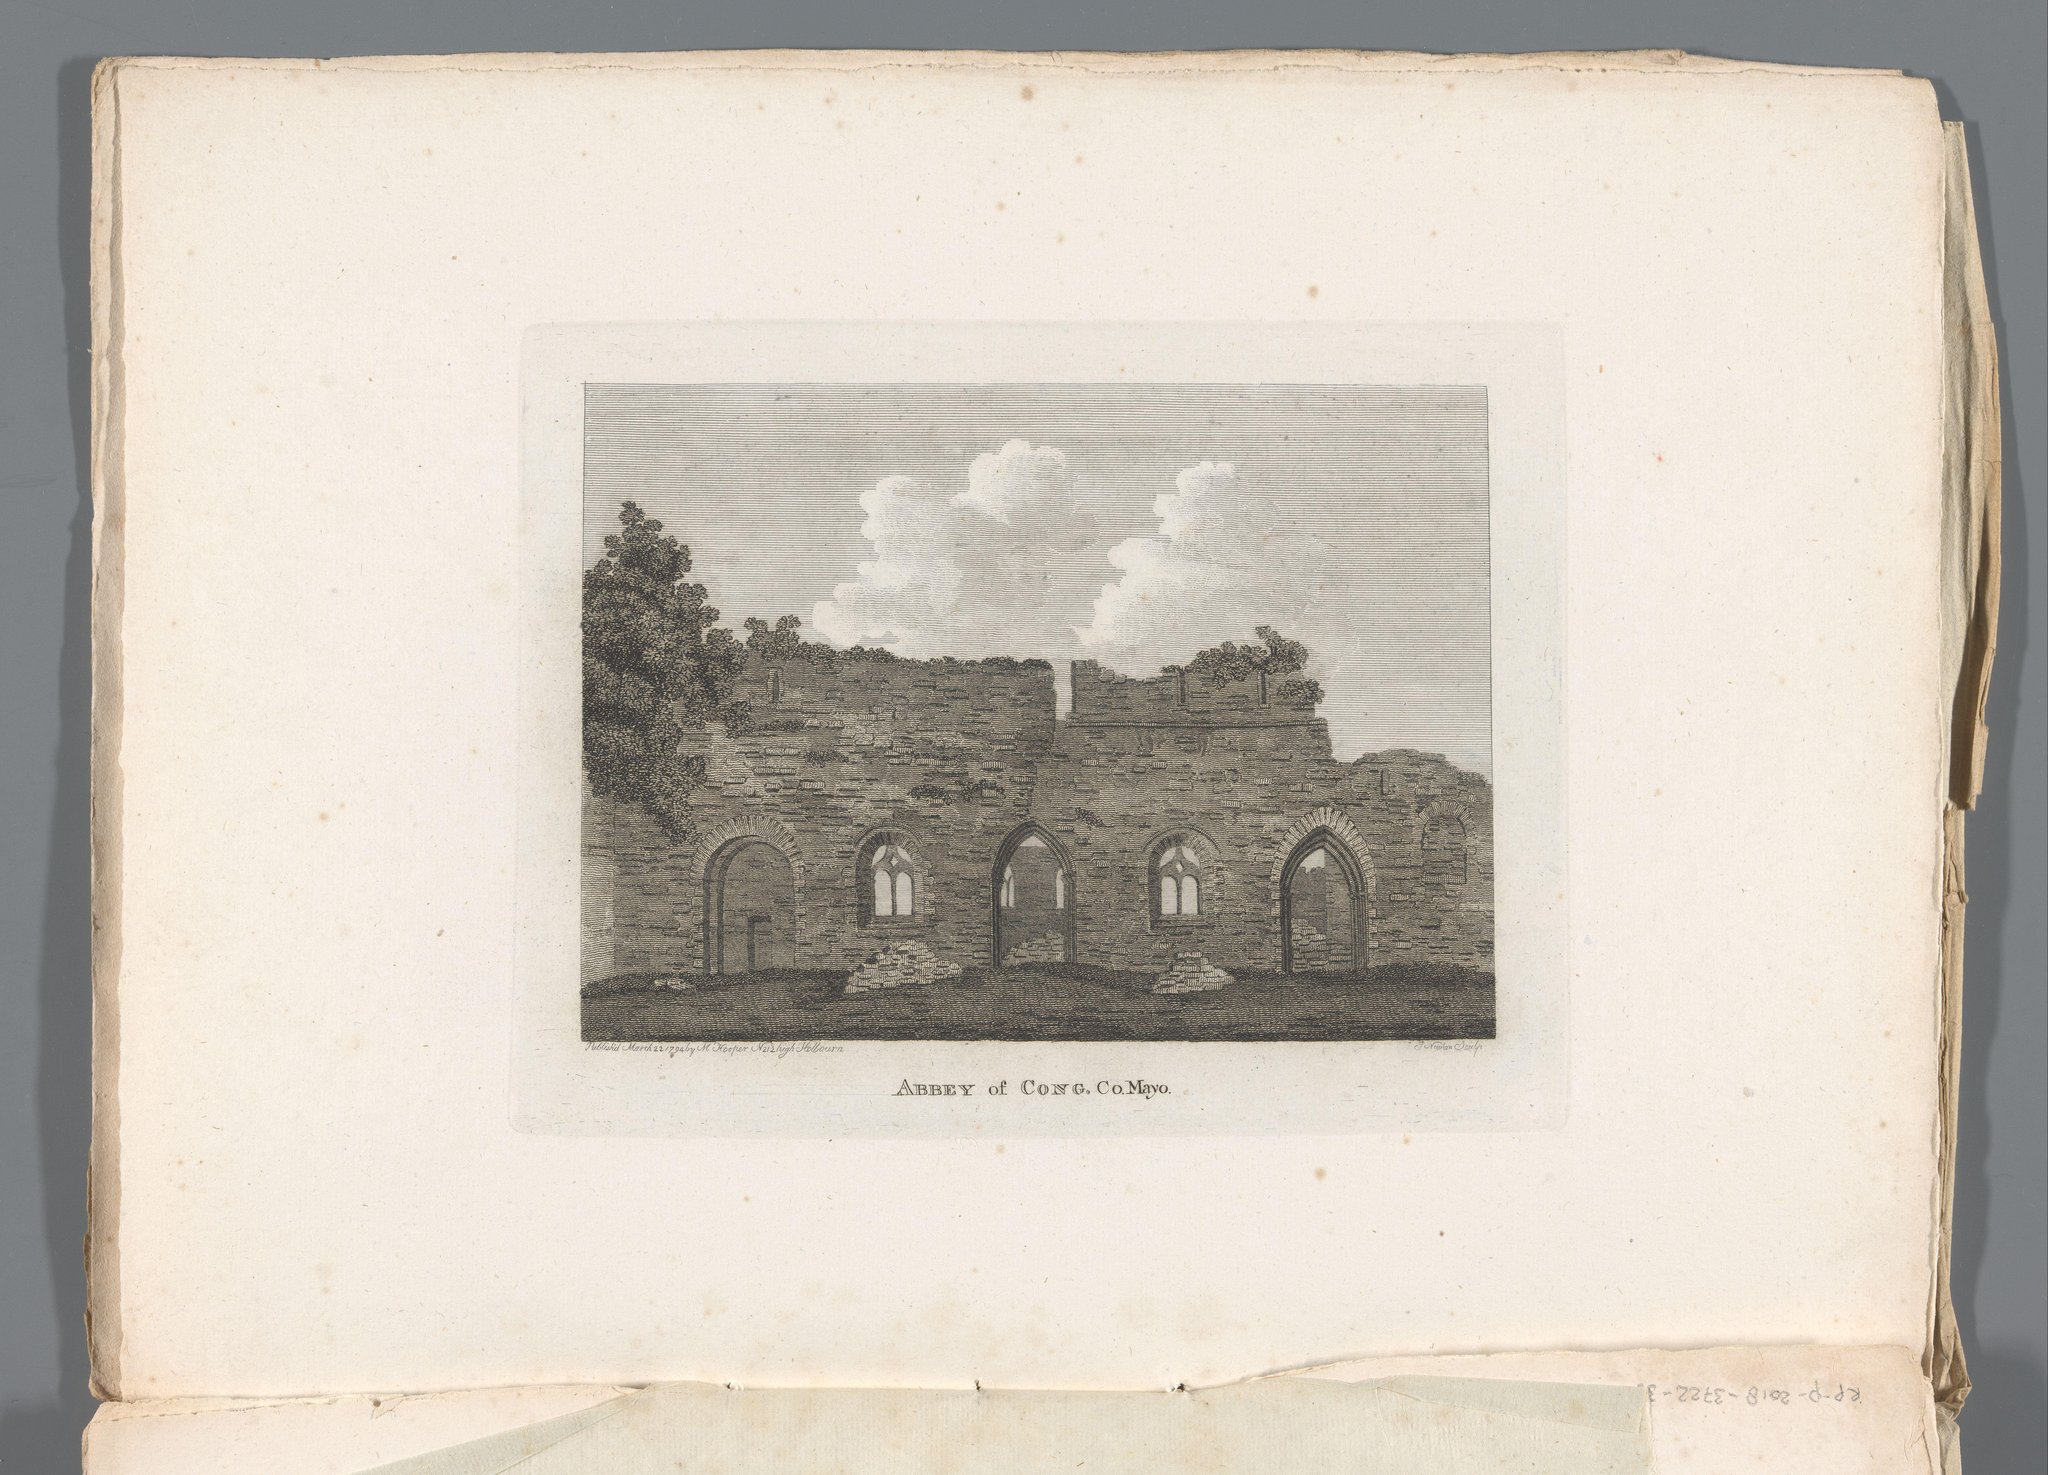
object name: print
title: Abbey of Cong. Co.Mayo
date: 1794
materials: paper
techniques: etching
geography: london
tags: city-view, and landscape with man-made constructions, abbey, monastery, convent ~ roman catholic church, landscape with ruins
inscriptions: date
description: Prent verschenen in: Grose, Francis. The antiquities of Ireland. Londen: S. Hooper, 1795, dl. 2.